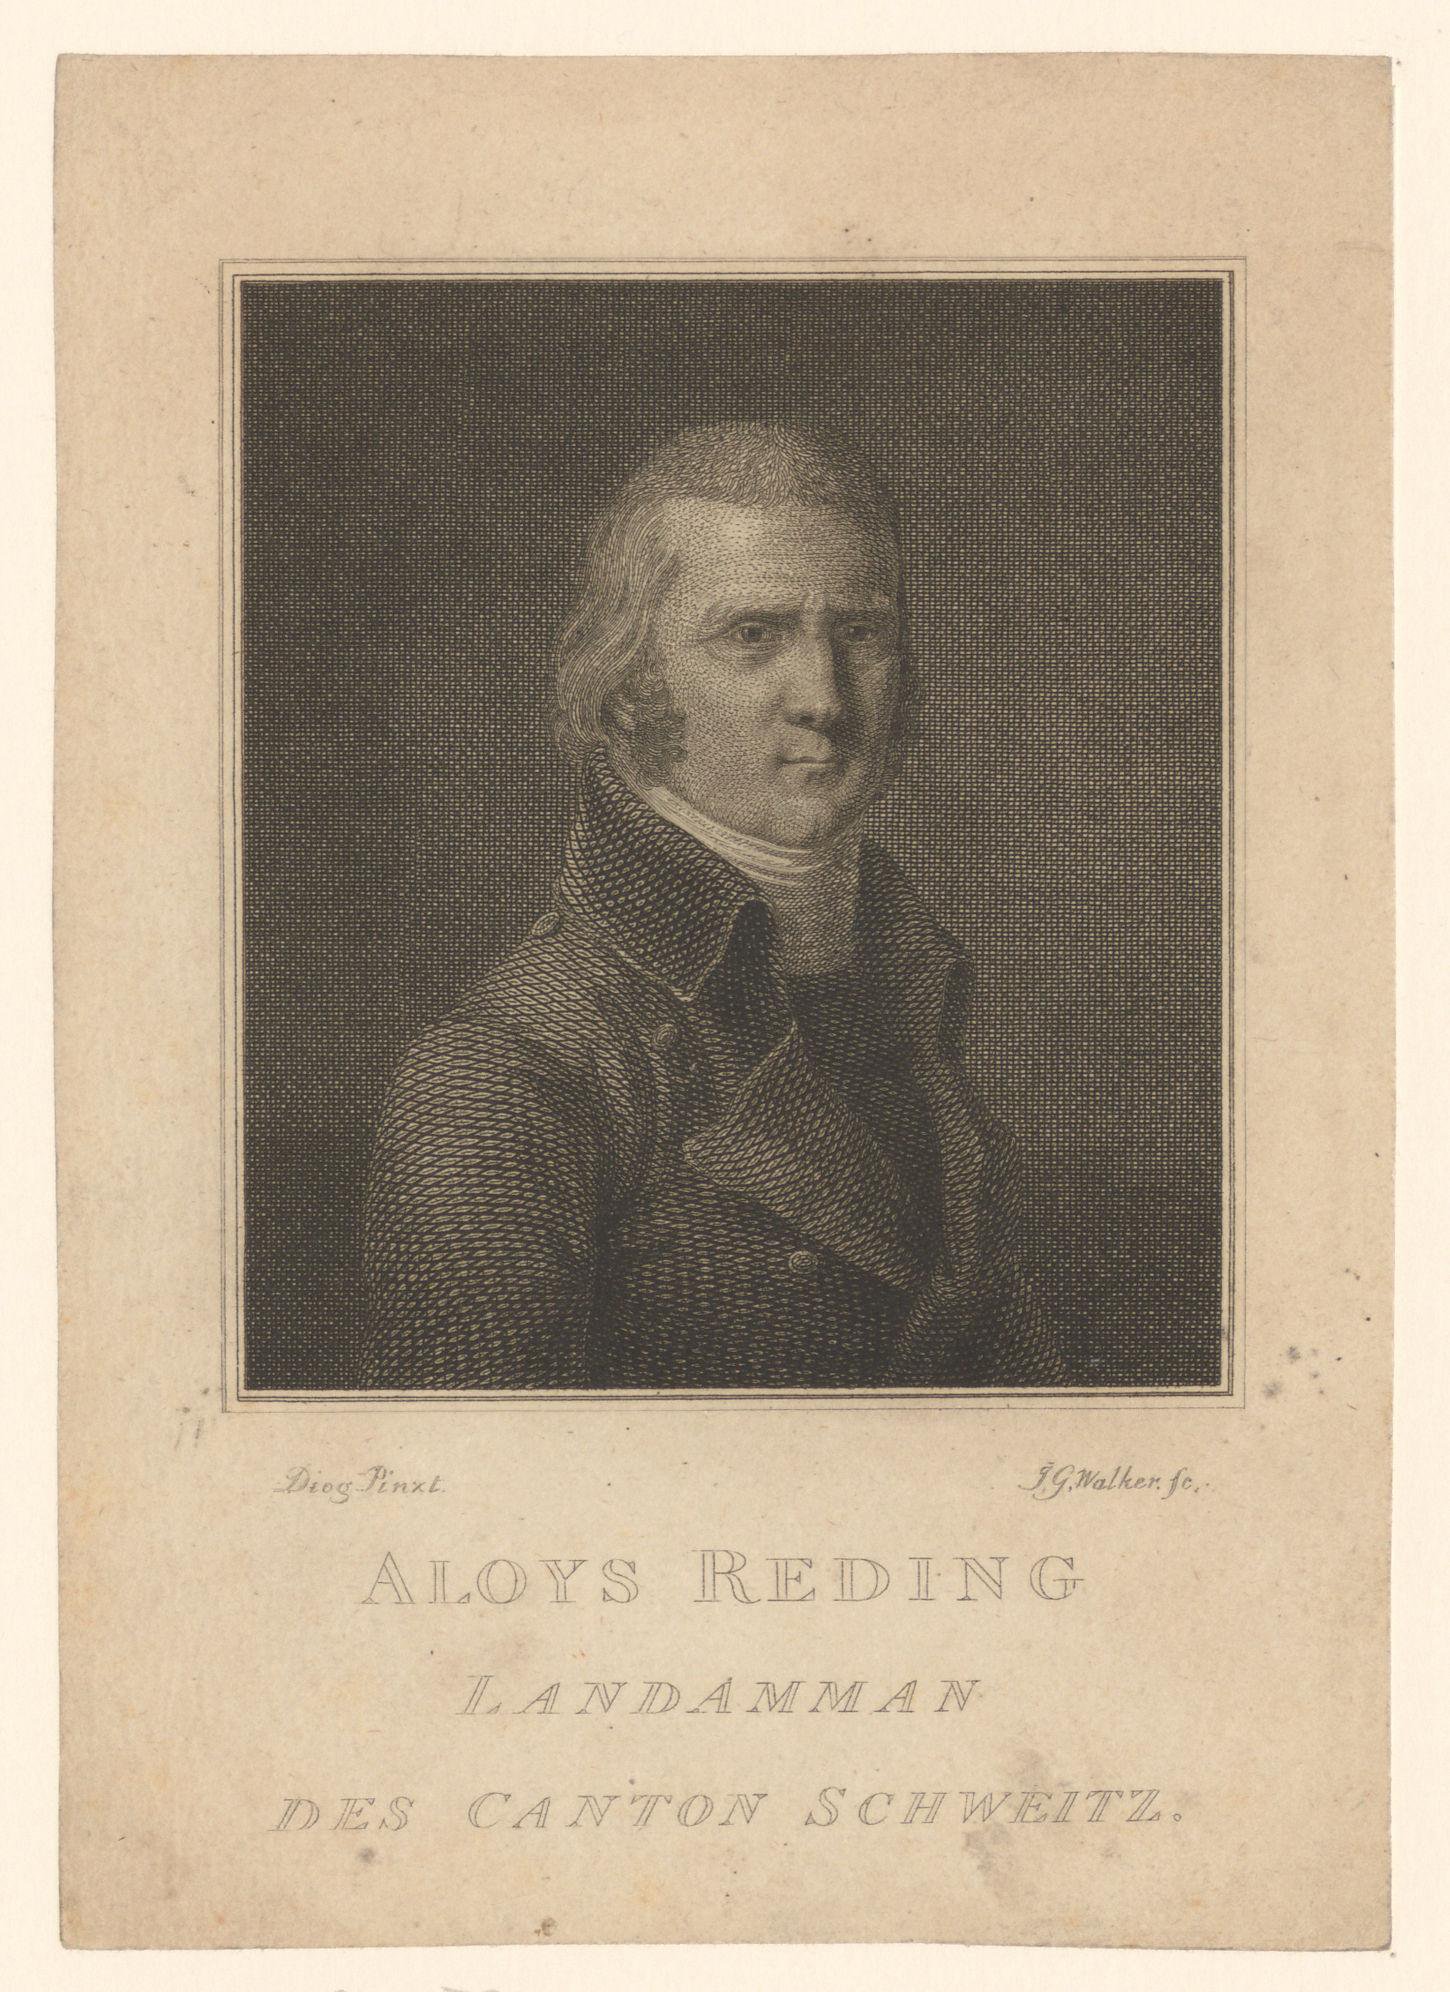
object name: print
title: Portret van Alois von Reding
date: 1803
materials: paper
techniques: engraving, etching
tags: historical persons, politician, e.g. party leader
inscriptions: collector's mark: Lugt 2228